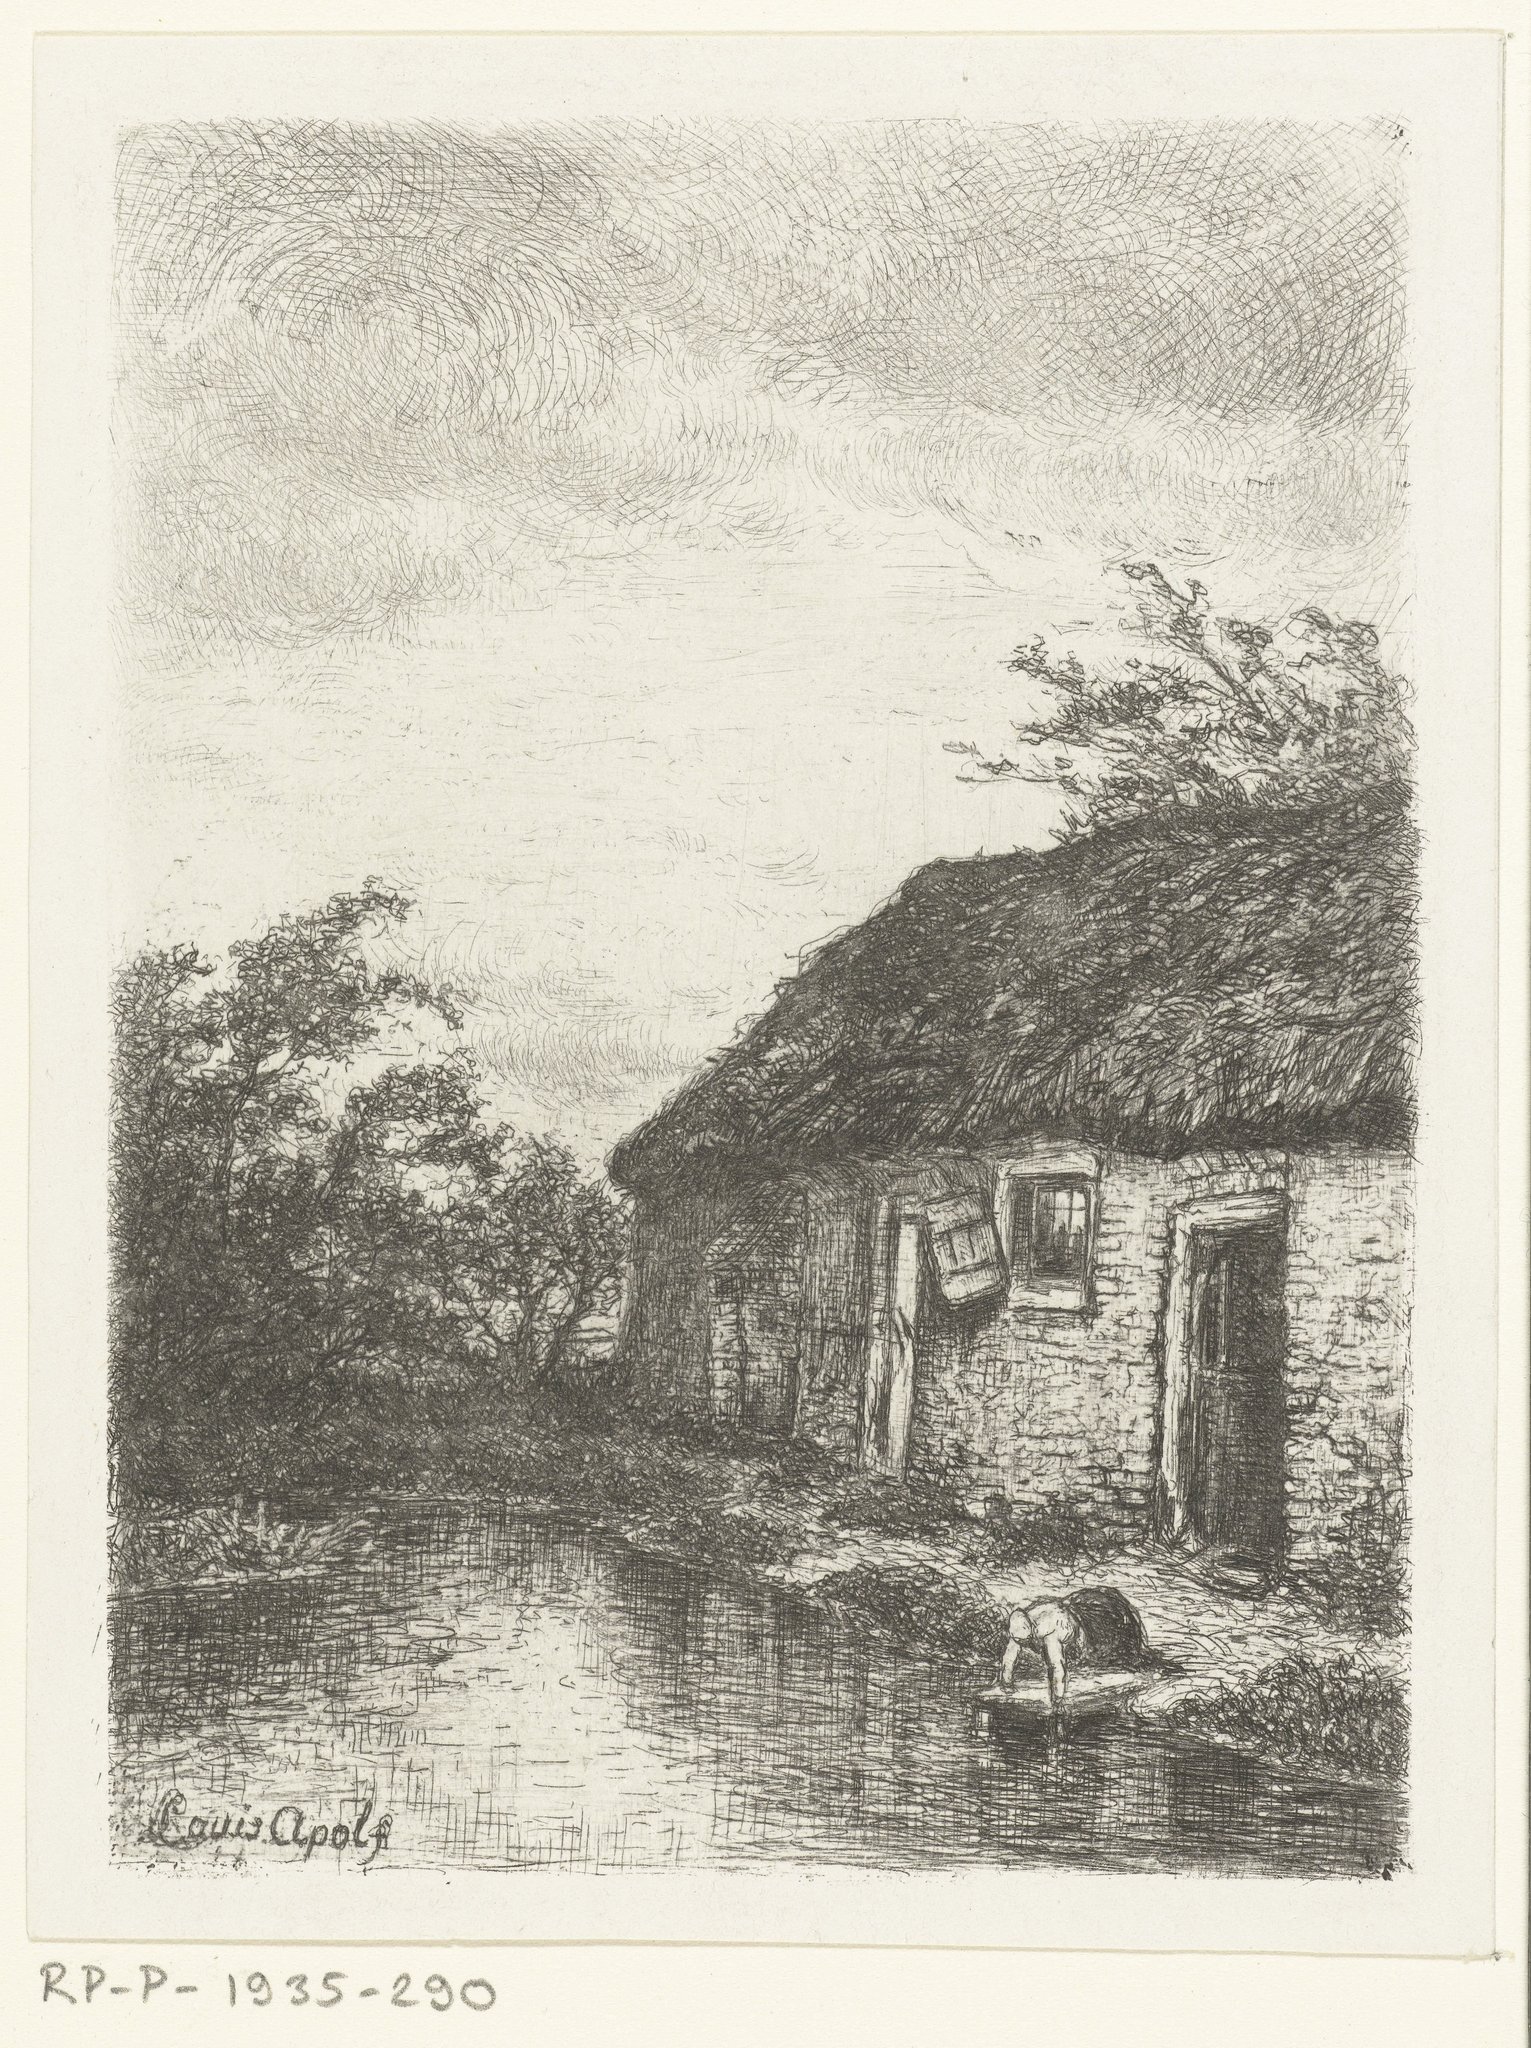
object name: print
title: Boerderij aan het water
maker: louis apol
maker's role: draughtsman, painter, print maker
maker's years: 1850-1936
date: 1860-1935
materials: paper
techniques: drypoint, etching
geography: netherlands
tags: farm or solitary house in landscape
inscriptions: collector's mark: Lugt 2760, collector's mark: Lugt 2228